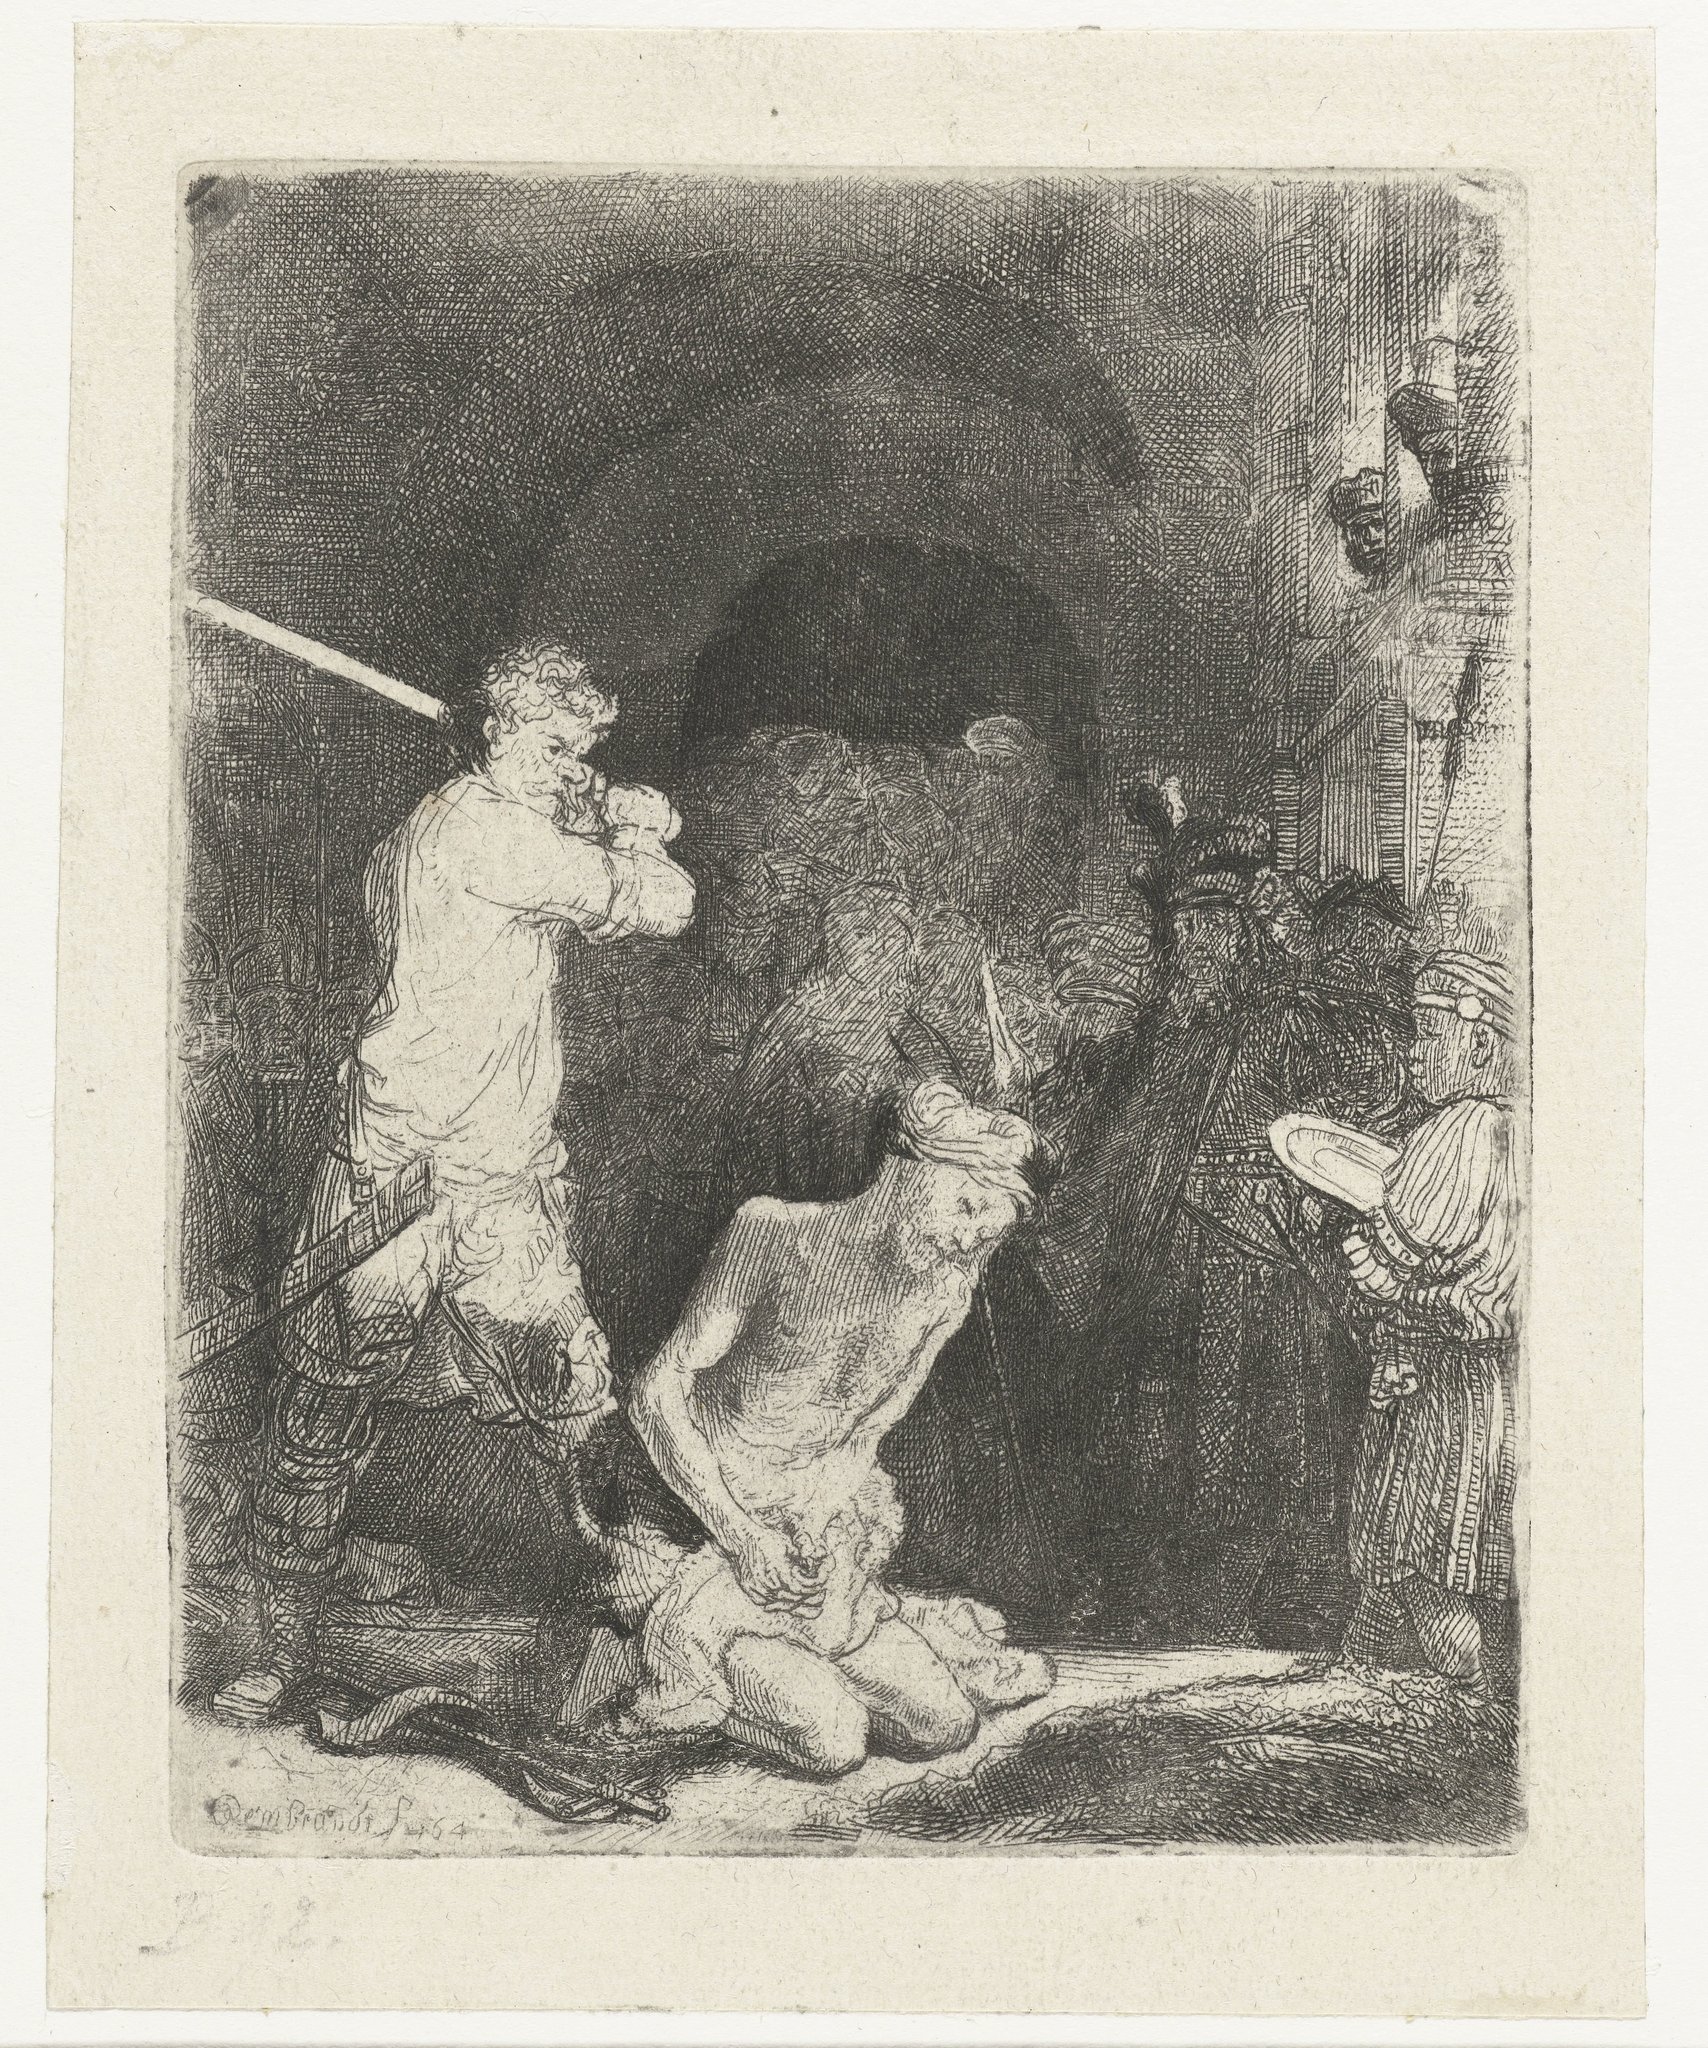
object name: print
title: The beheading of St John the Baptist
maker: rembrandt van rijn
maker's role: draughtsman, painter, print maker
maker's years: 1606-1669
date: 1640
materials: paper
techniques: drypoint, etching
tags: the beheading of john the baptist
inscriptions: inscription: ‘Coppier’, signature and date: ‘Rembrandt f 1640’